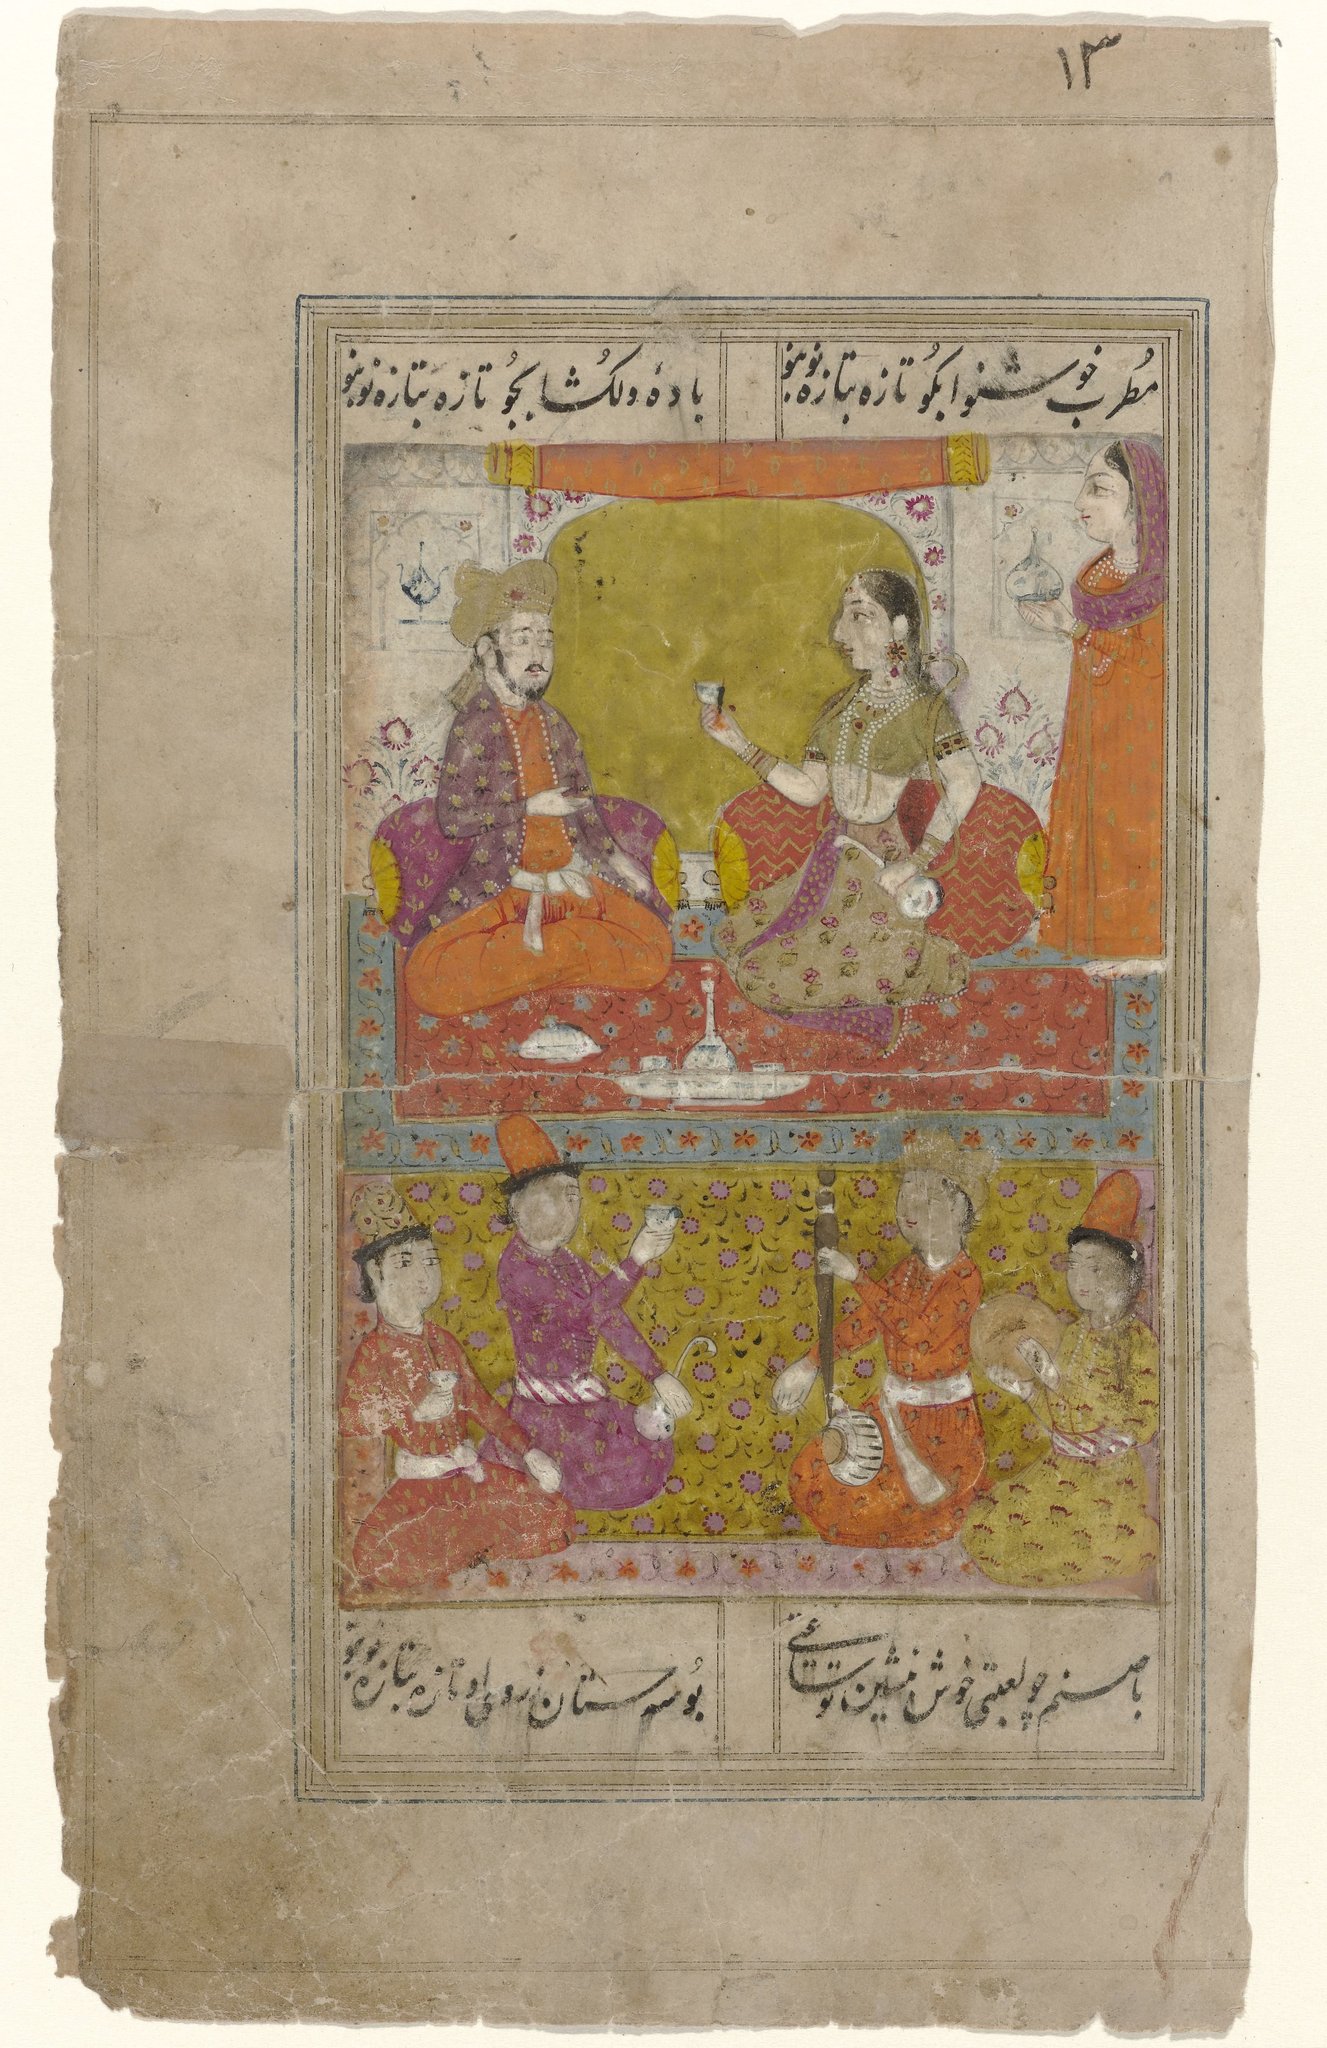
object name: indian miniature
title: Twee banen met een paartje op de bovenste baan en vier musici op de onderste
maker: Anonymous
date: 1790-1810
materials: paper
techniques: brush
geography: kashmir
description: Het blad is in twee banen verdeeld met een paartje en musici boven en onder en twee eenregelige kolommen tekst boven en onder de voorstelling in oud-Perzisch schrift; op verso een tekst in ruitvormen.